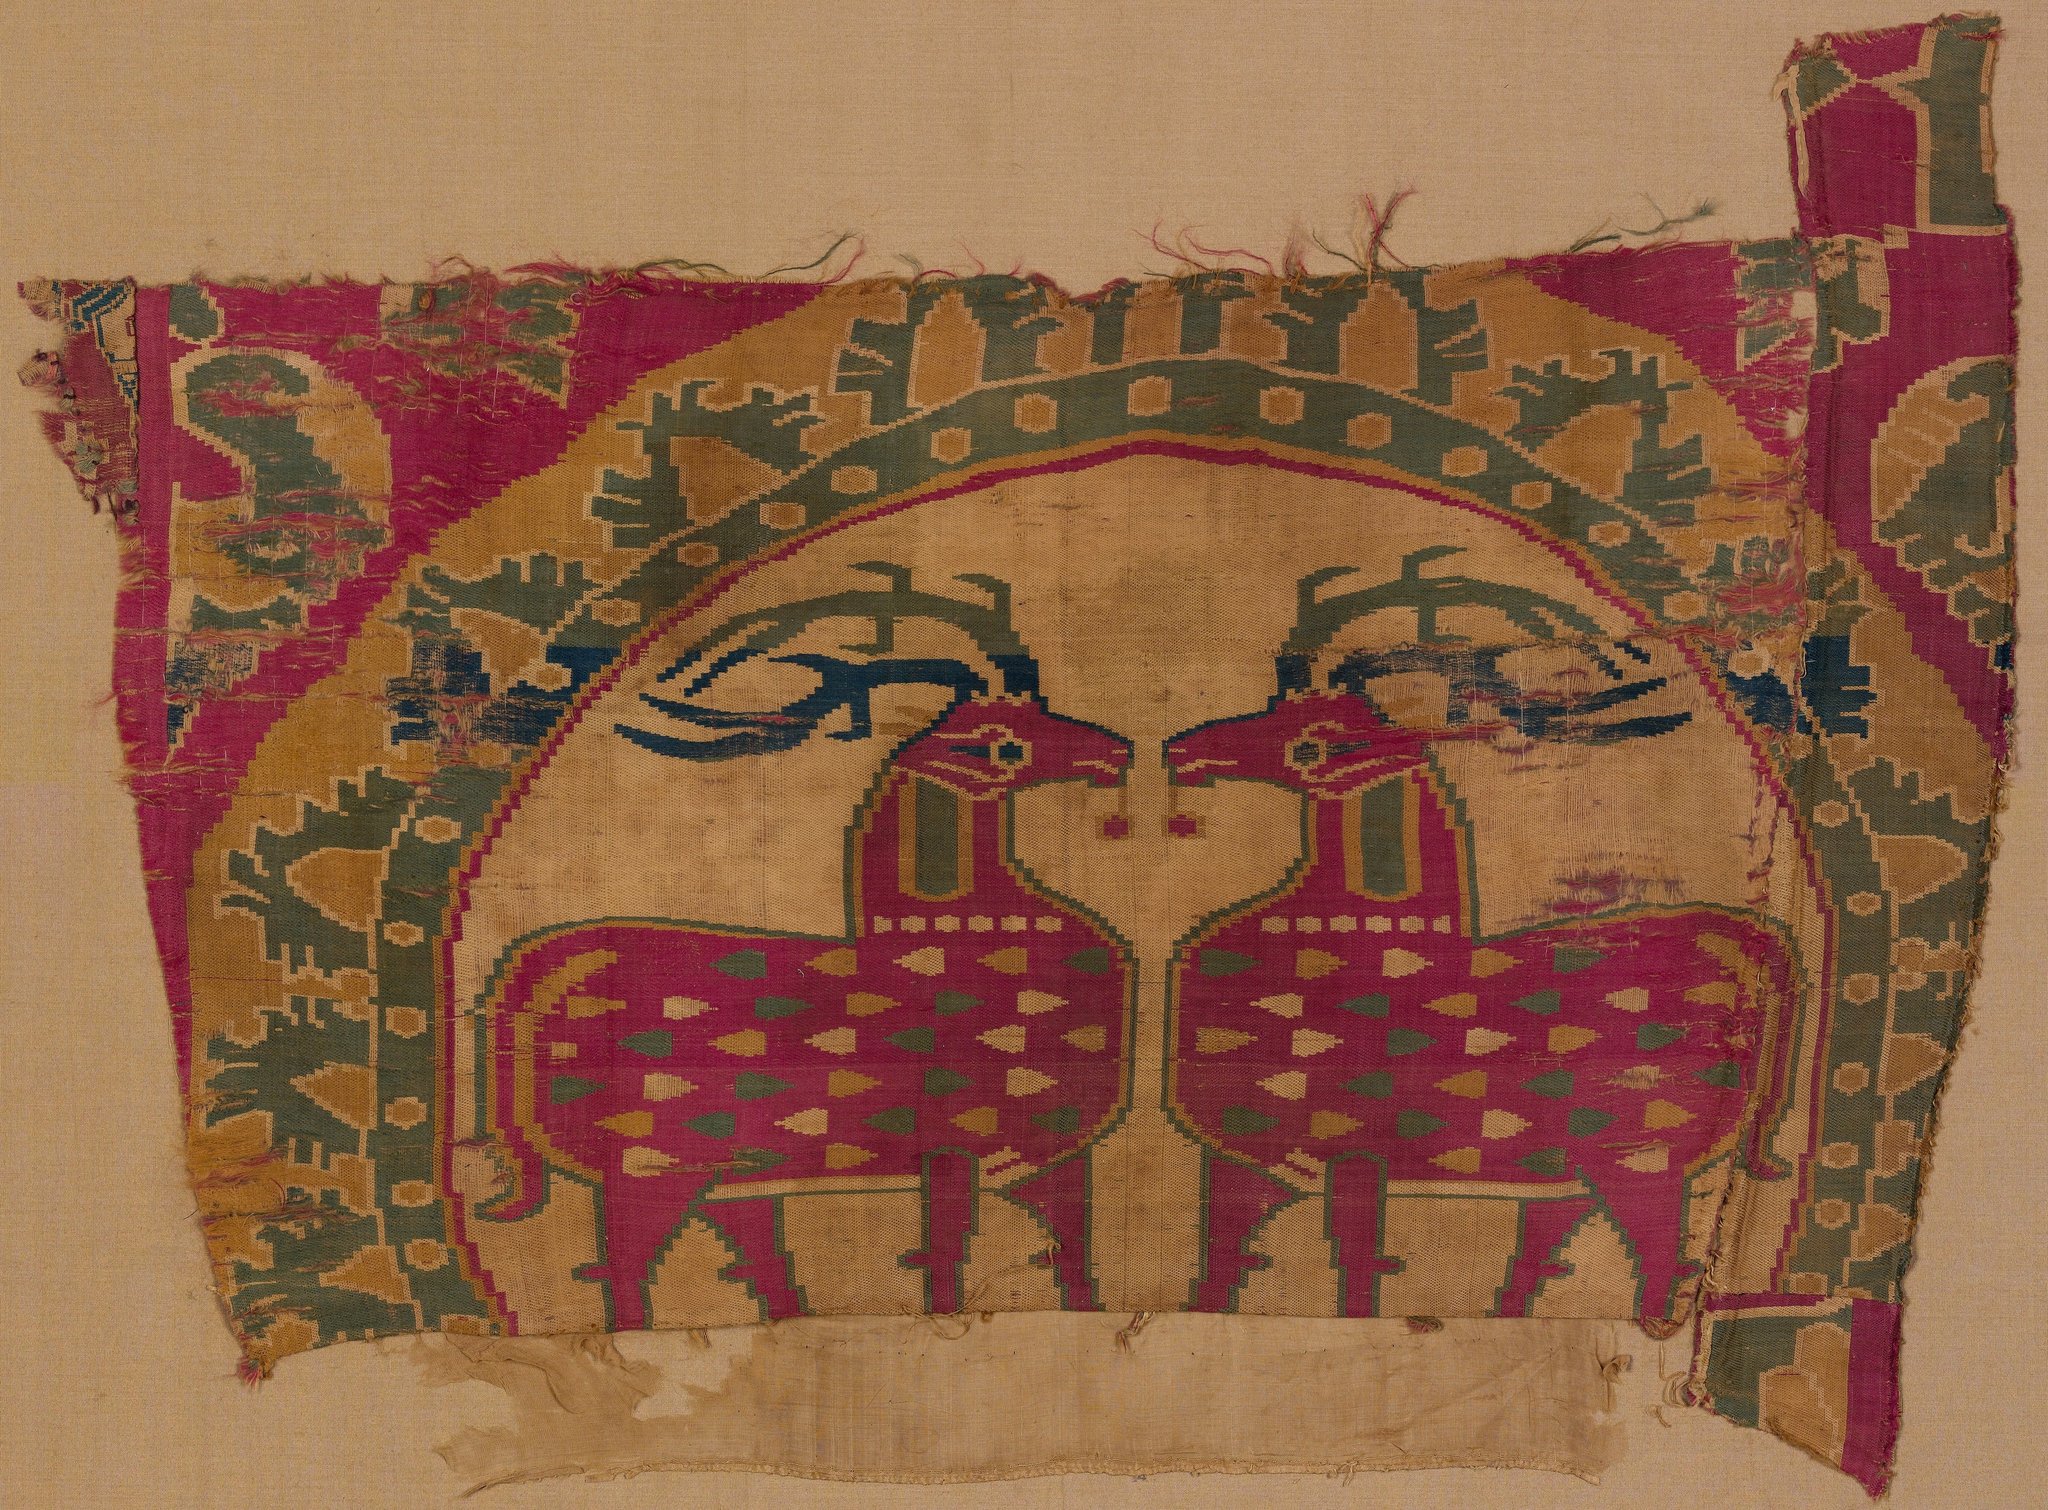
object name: textile fragment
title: Textile Fragment with Confronted Deer in Partial Pearl Roundel with Serrated Outer Border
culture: iran or sogdiana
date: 701-900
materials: silk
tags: deer